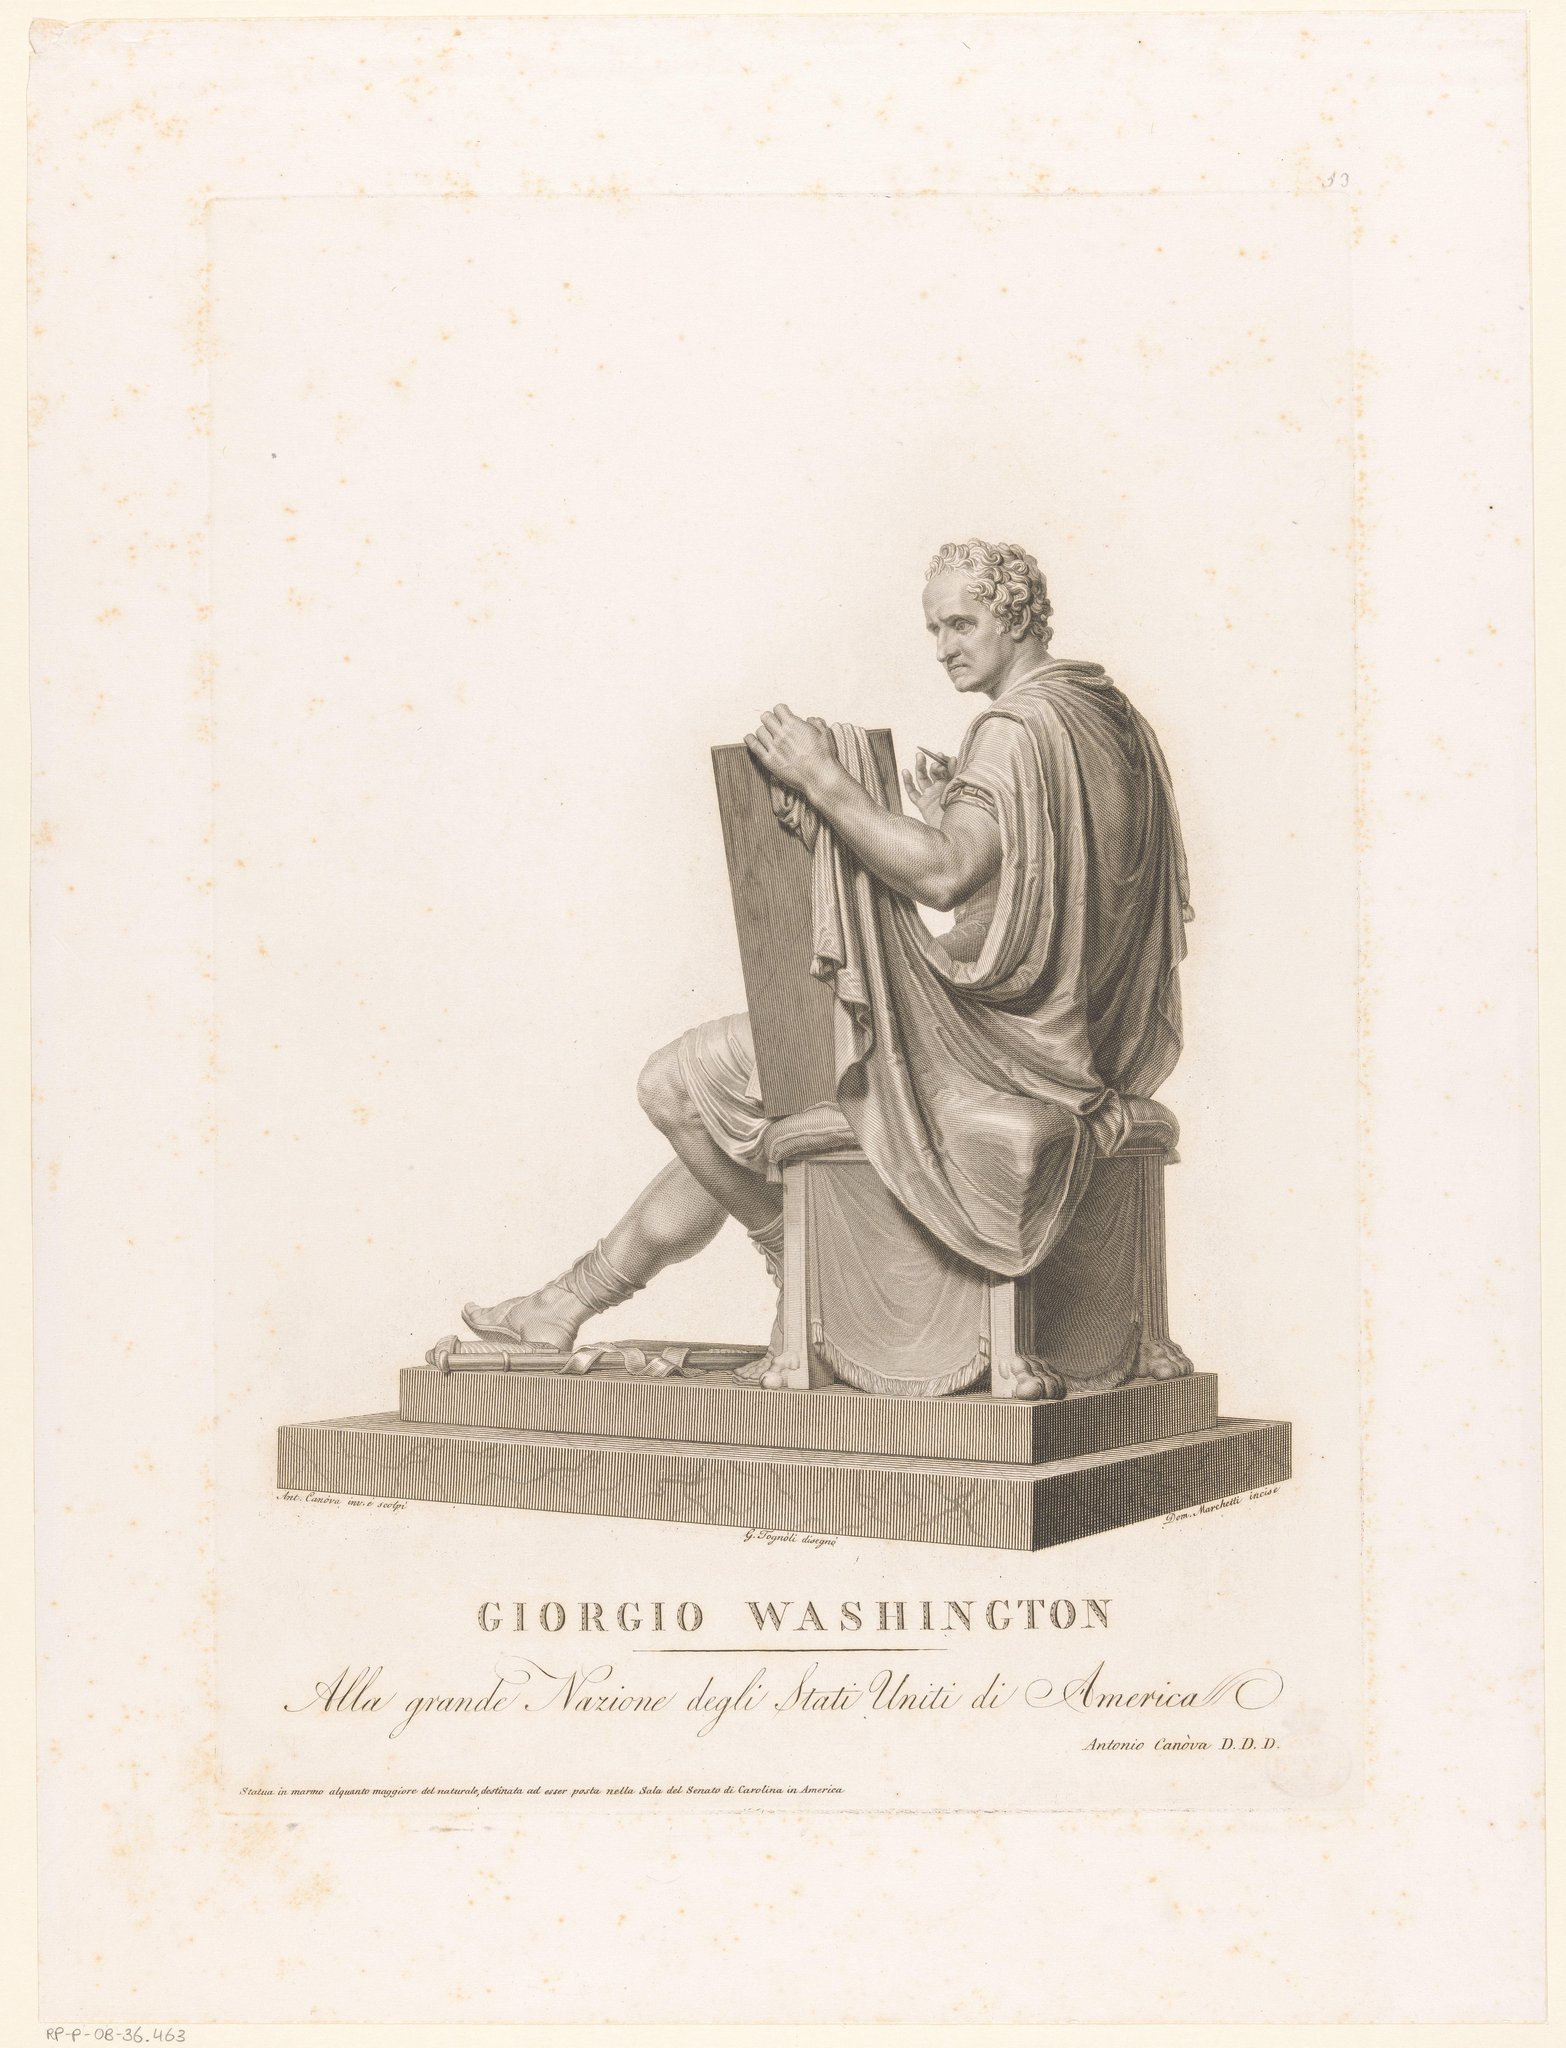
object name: print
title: Standbeeld van George Washington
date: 1790-1844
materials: paper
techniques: engraving, etching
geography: italy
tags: president ~ head of republic, piece of sculpture, reproduction of a piece of sculpture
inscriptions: collector's mark: Lugt 12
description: Standbeeld van president George Washington van de Verenigde Staten, zittend op een stoel met een tablet en een pen in zijn handen, door de Italiaanse beeldhouwer Antonio Canova. Opdracht onder voorstelling.